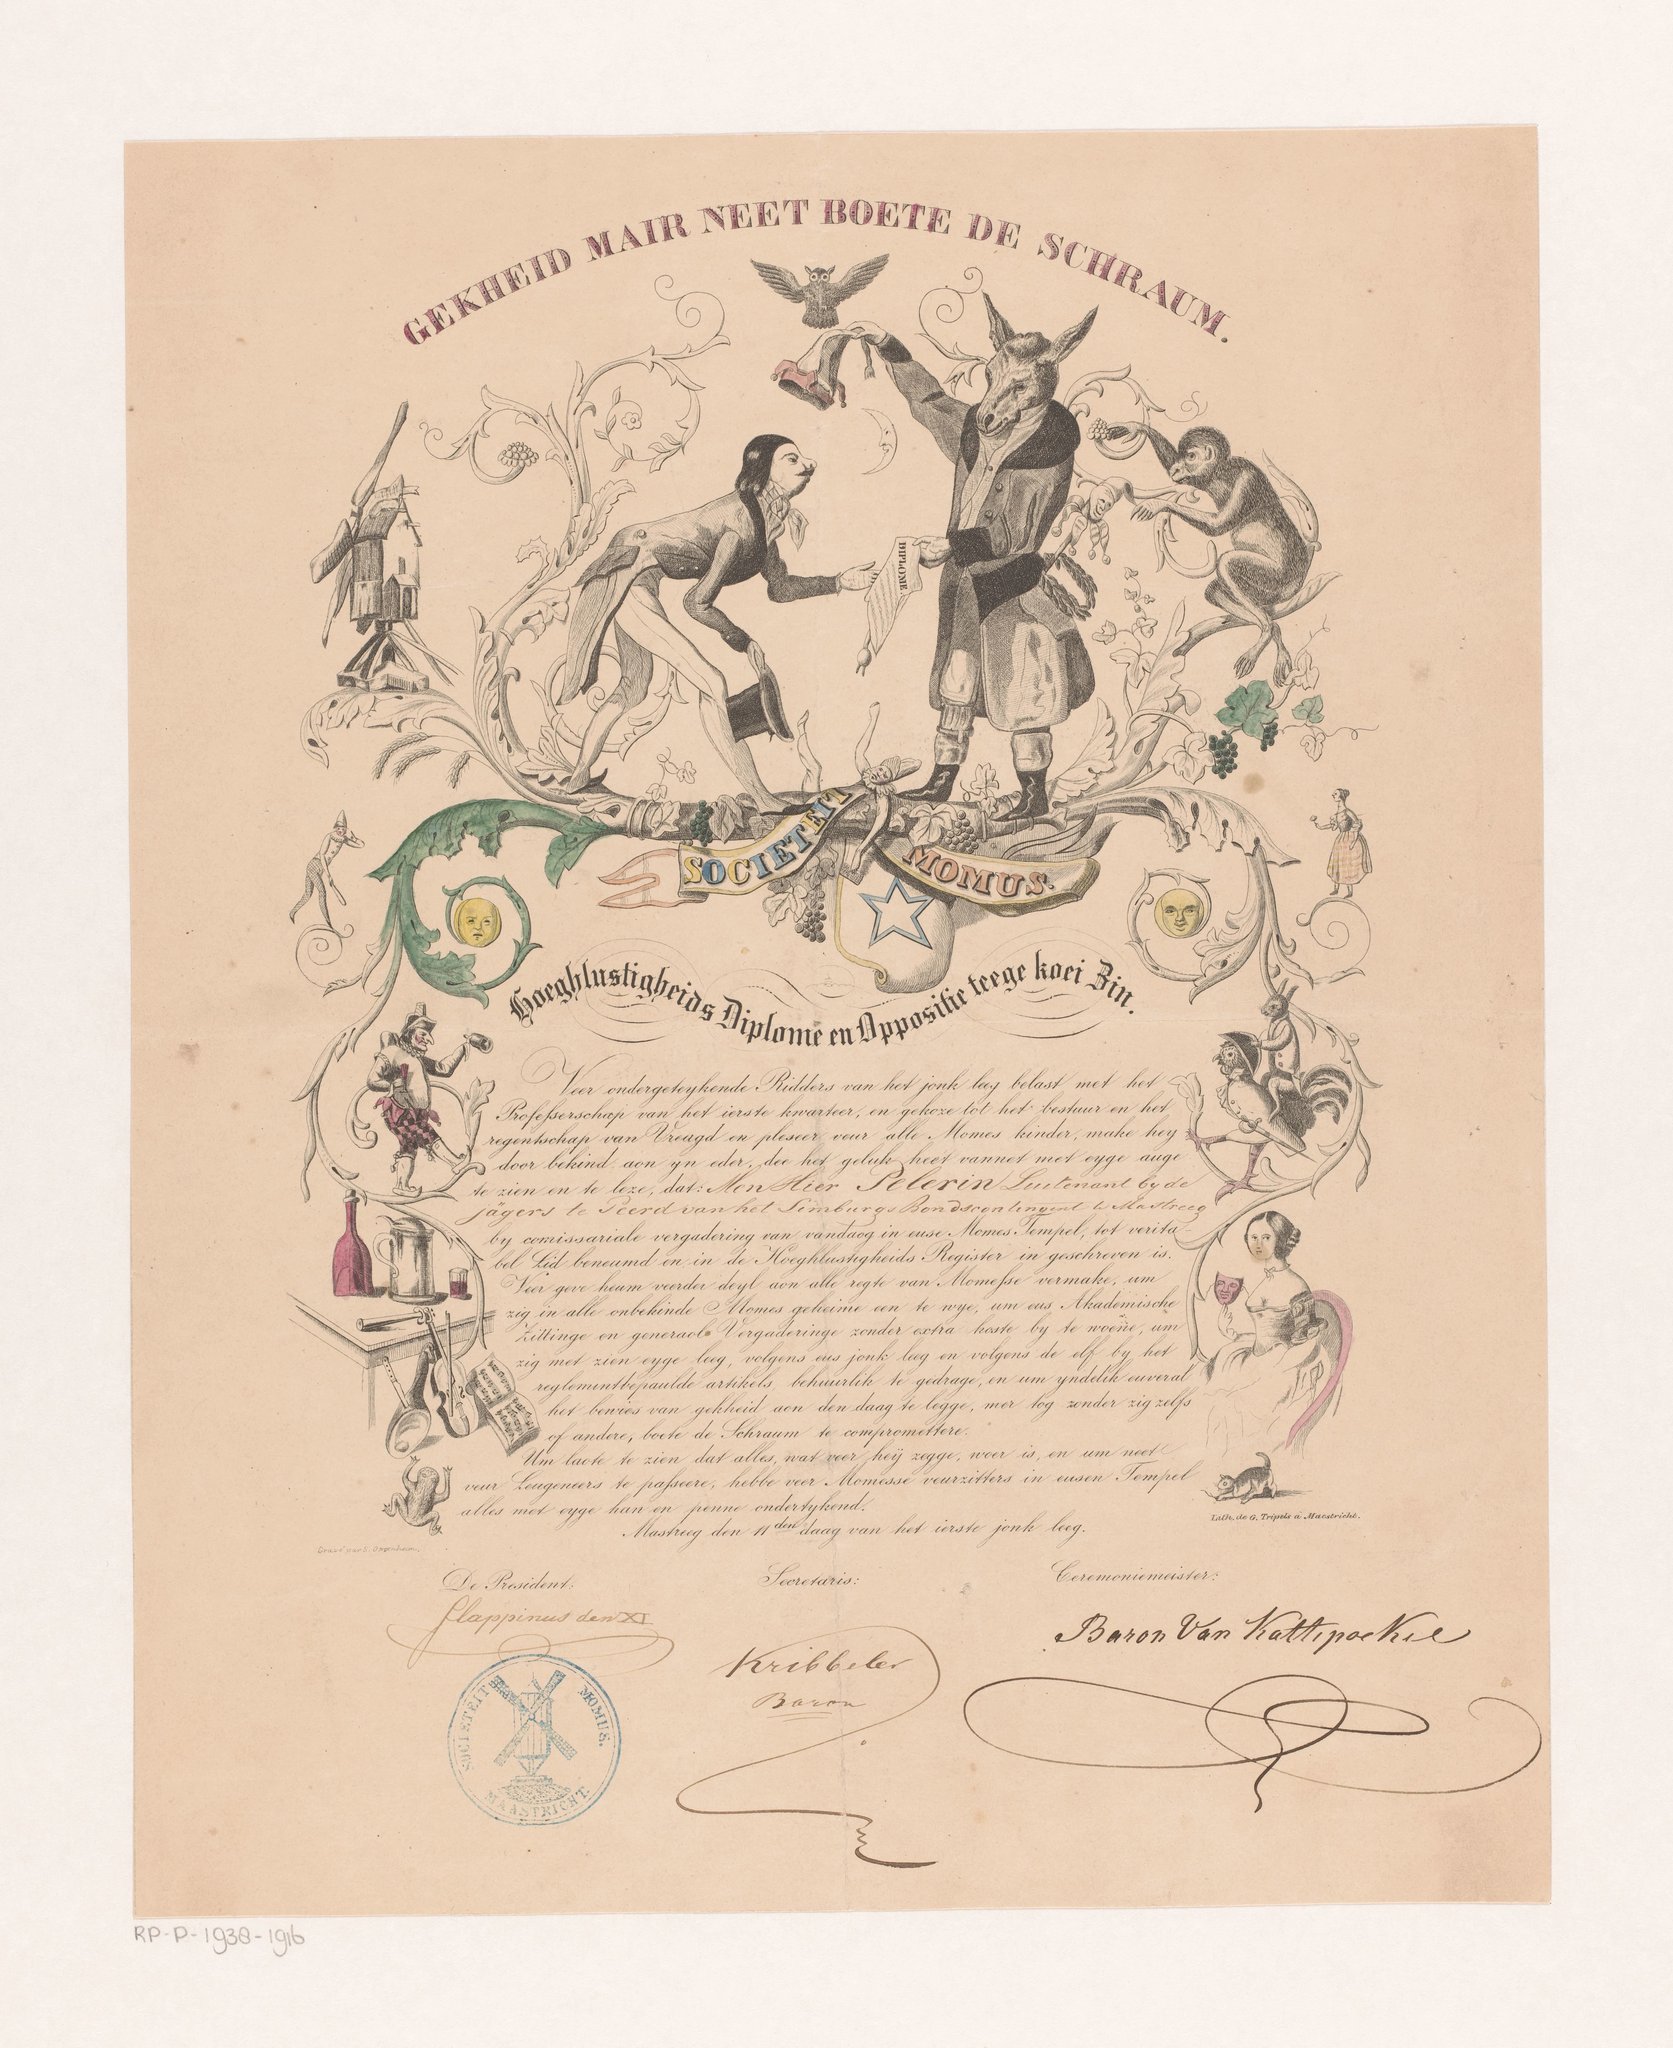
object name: print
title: Man met ezelskop overhandigt buigende man een oorkonde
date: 1880-1890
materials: paper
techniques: hand coloring, lithograph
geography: maastricht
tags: maastricht, ass, donkey, head bent forward; bowing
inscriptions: stamp: ‘Societeit Momus Maastricht’, collector's mark: Lugt 2760, collector's mark: Lugt 2228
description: Een man met ezelskop en narrenstok geeft een oorkonde aan de buigende man voor hem. In zijn rechterhand houdt hij een narrenmuts. De buigende man neemt zijn hoed af. Het tweetal staat in een ornamentele omlijsting met een molen, een aap, een nar, maskers, een konijn zittend op een haan, muziekinstrumenten en een vrouw met een masker in haar hand. Aan de onderzijde een tekst in Limburgs dialect getekend door de president, secretaris en ceremoniemeester van herensociëteit en carnavalsvereniging Momus te Maastricht.